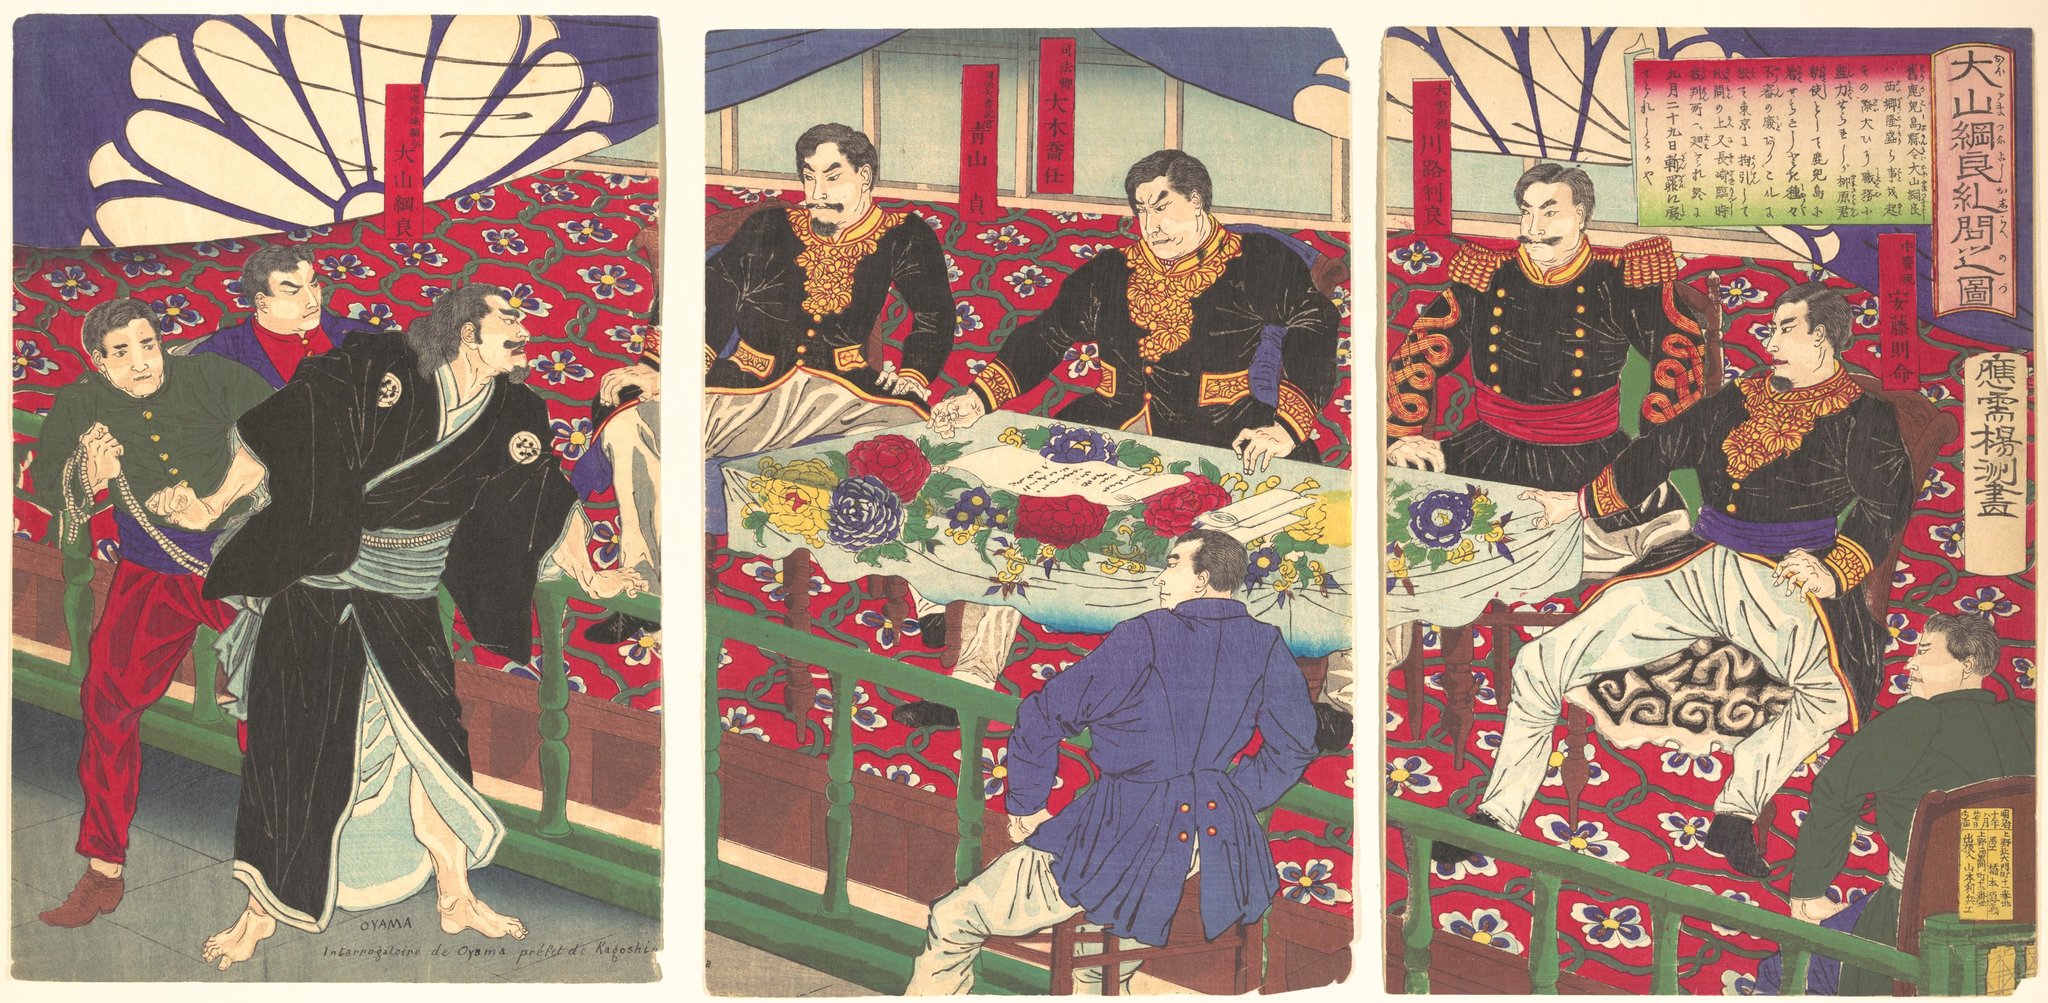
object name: print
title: Illustration of the Inquisition of Ōyama Tsunayoshi (Ōyama Tsunayoshi kyūmon no zu)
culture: japanese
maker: yōshū (hashimoto) chikanobu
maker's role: artist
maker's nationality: japanese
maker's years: 1838-1912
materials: ink, paper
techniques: woodblock print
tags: men